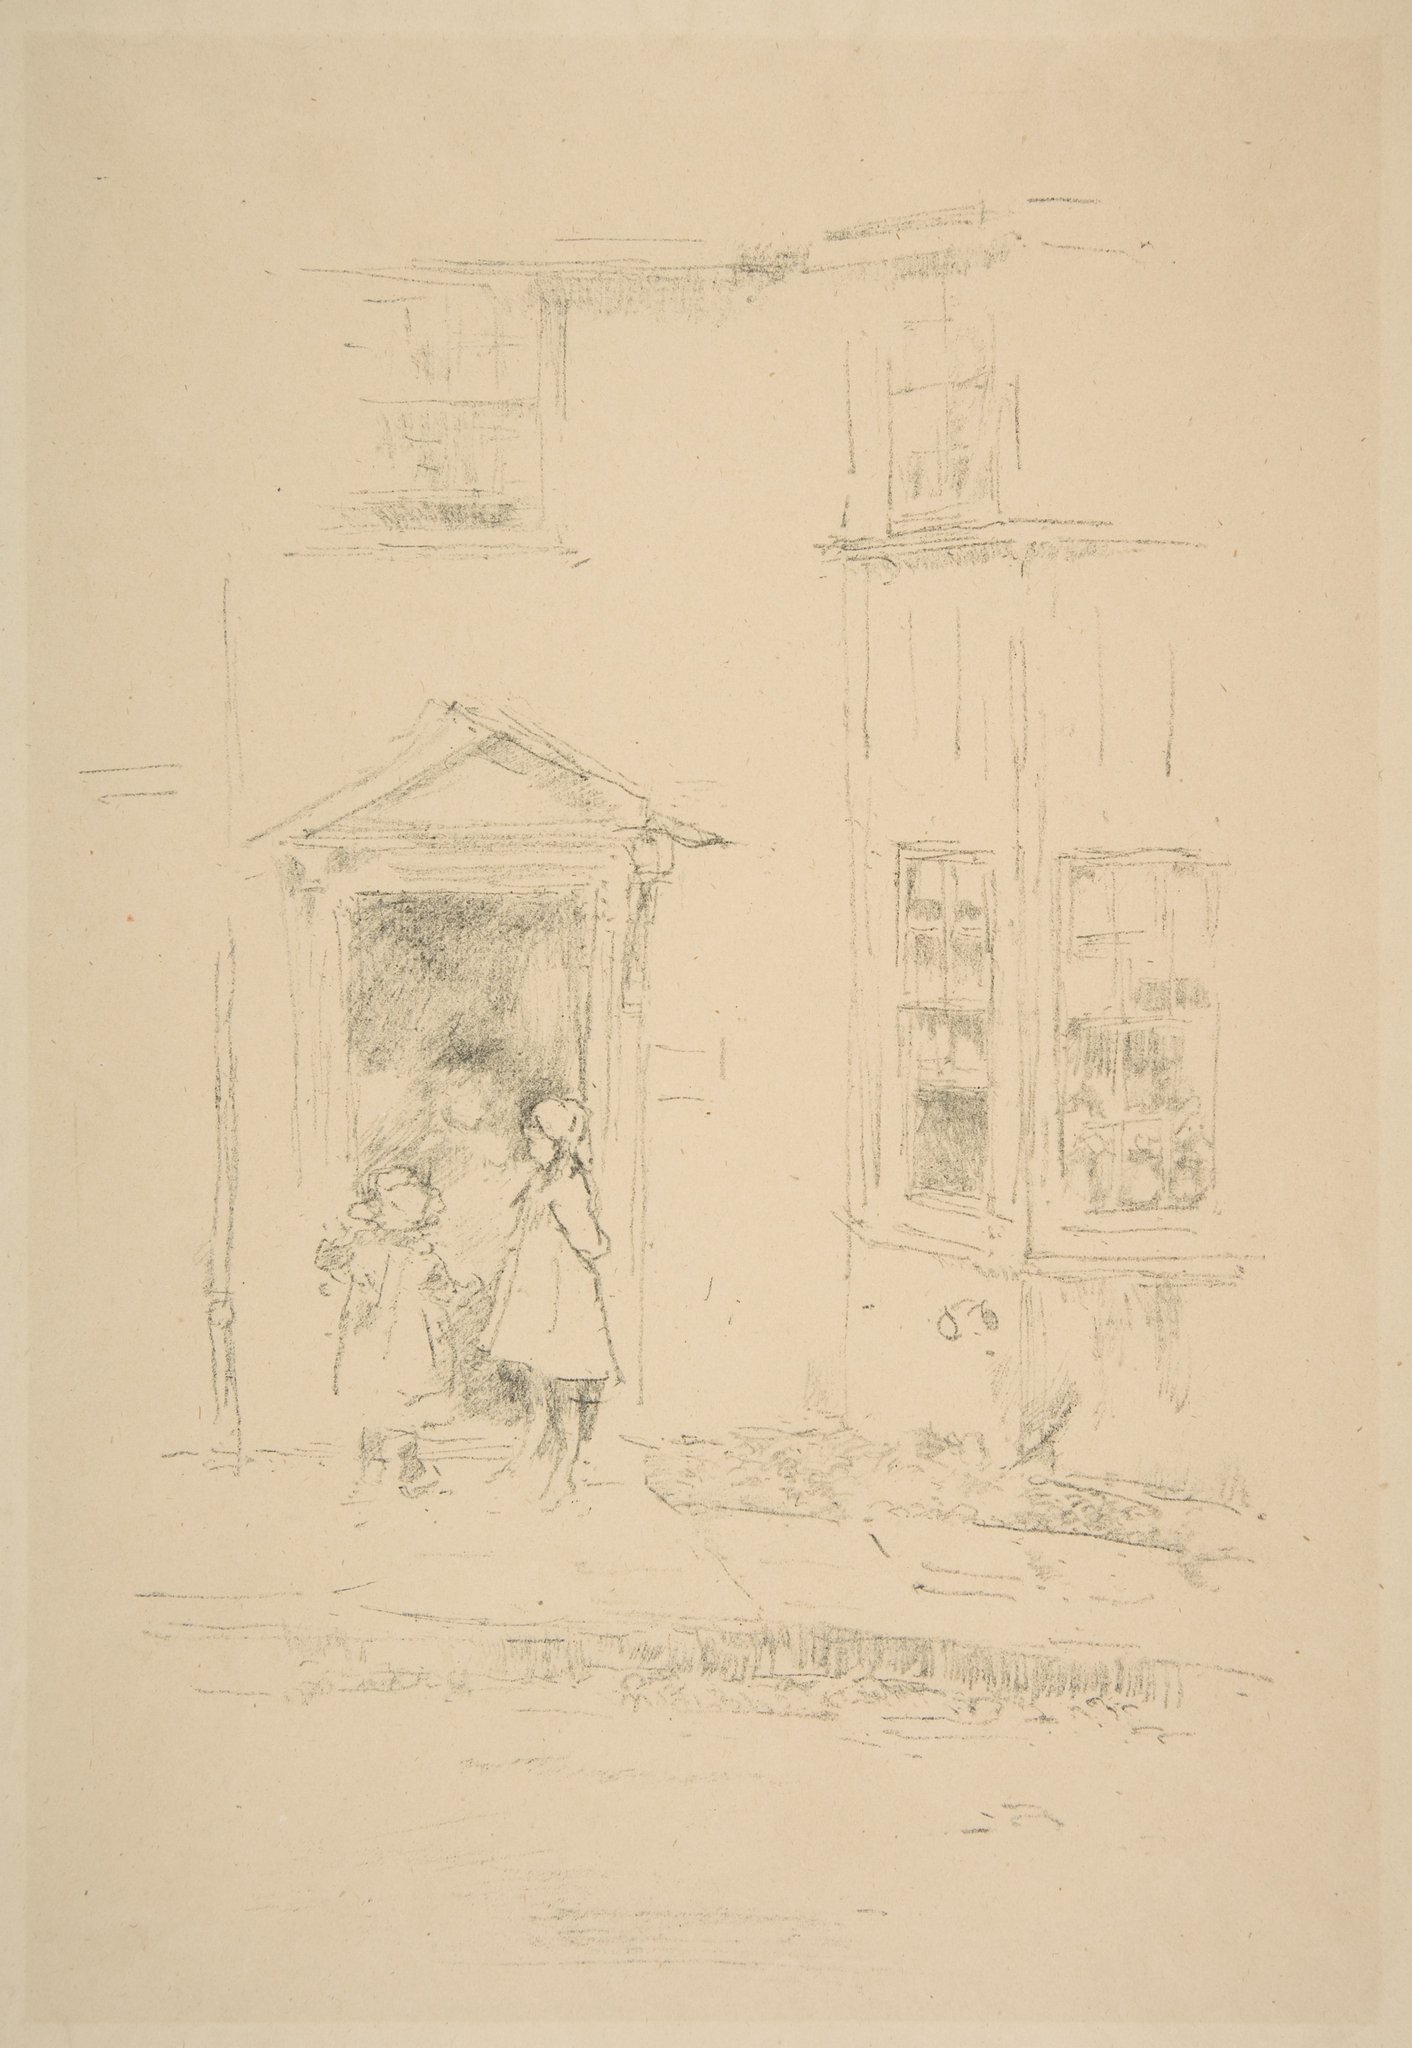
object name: print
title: Little Doorway, Lyme Regis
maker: james mcneill whistler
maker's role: artist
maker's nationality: american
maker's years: 1834-1903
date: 1895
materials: ink, paper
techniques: printing, lithography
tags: doorways,girls